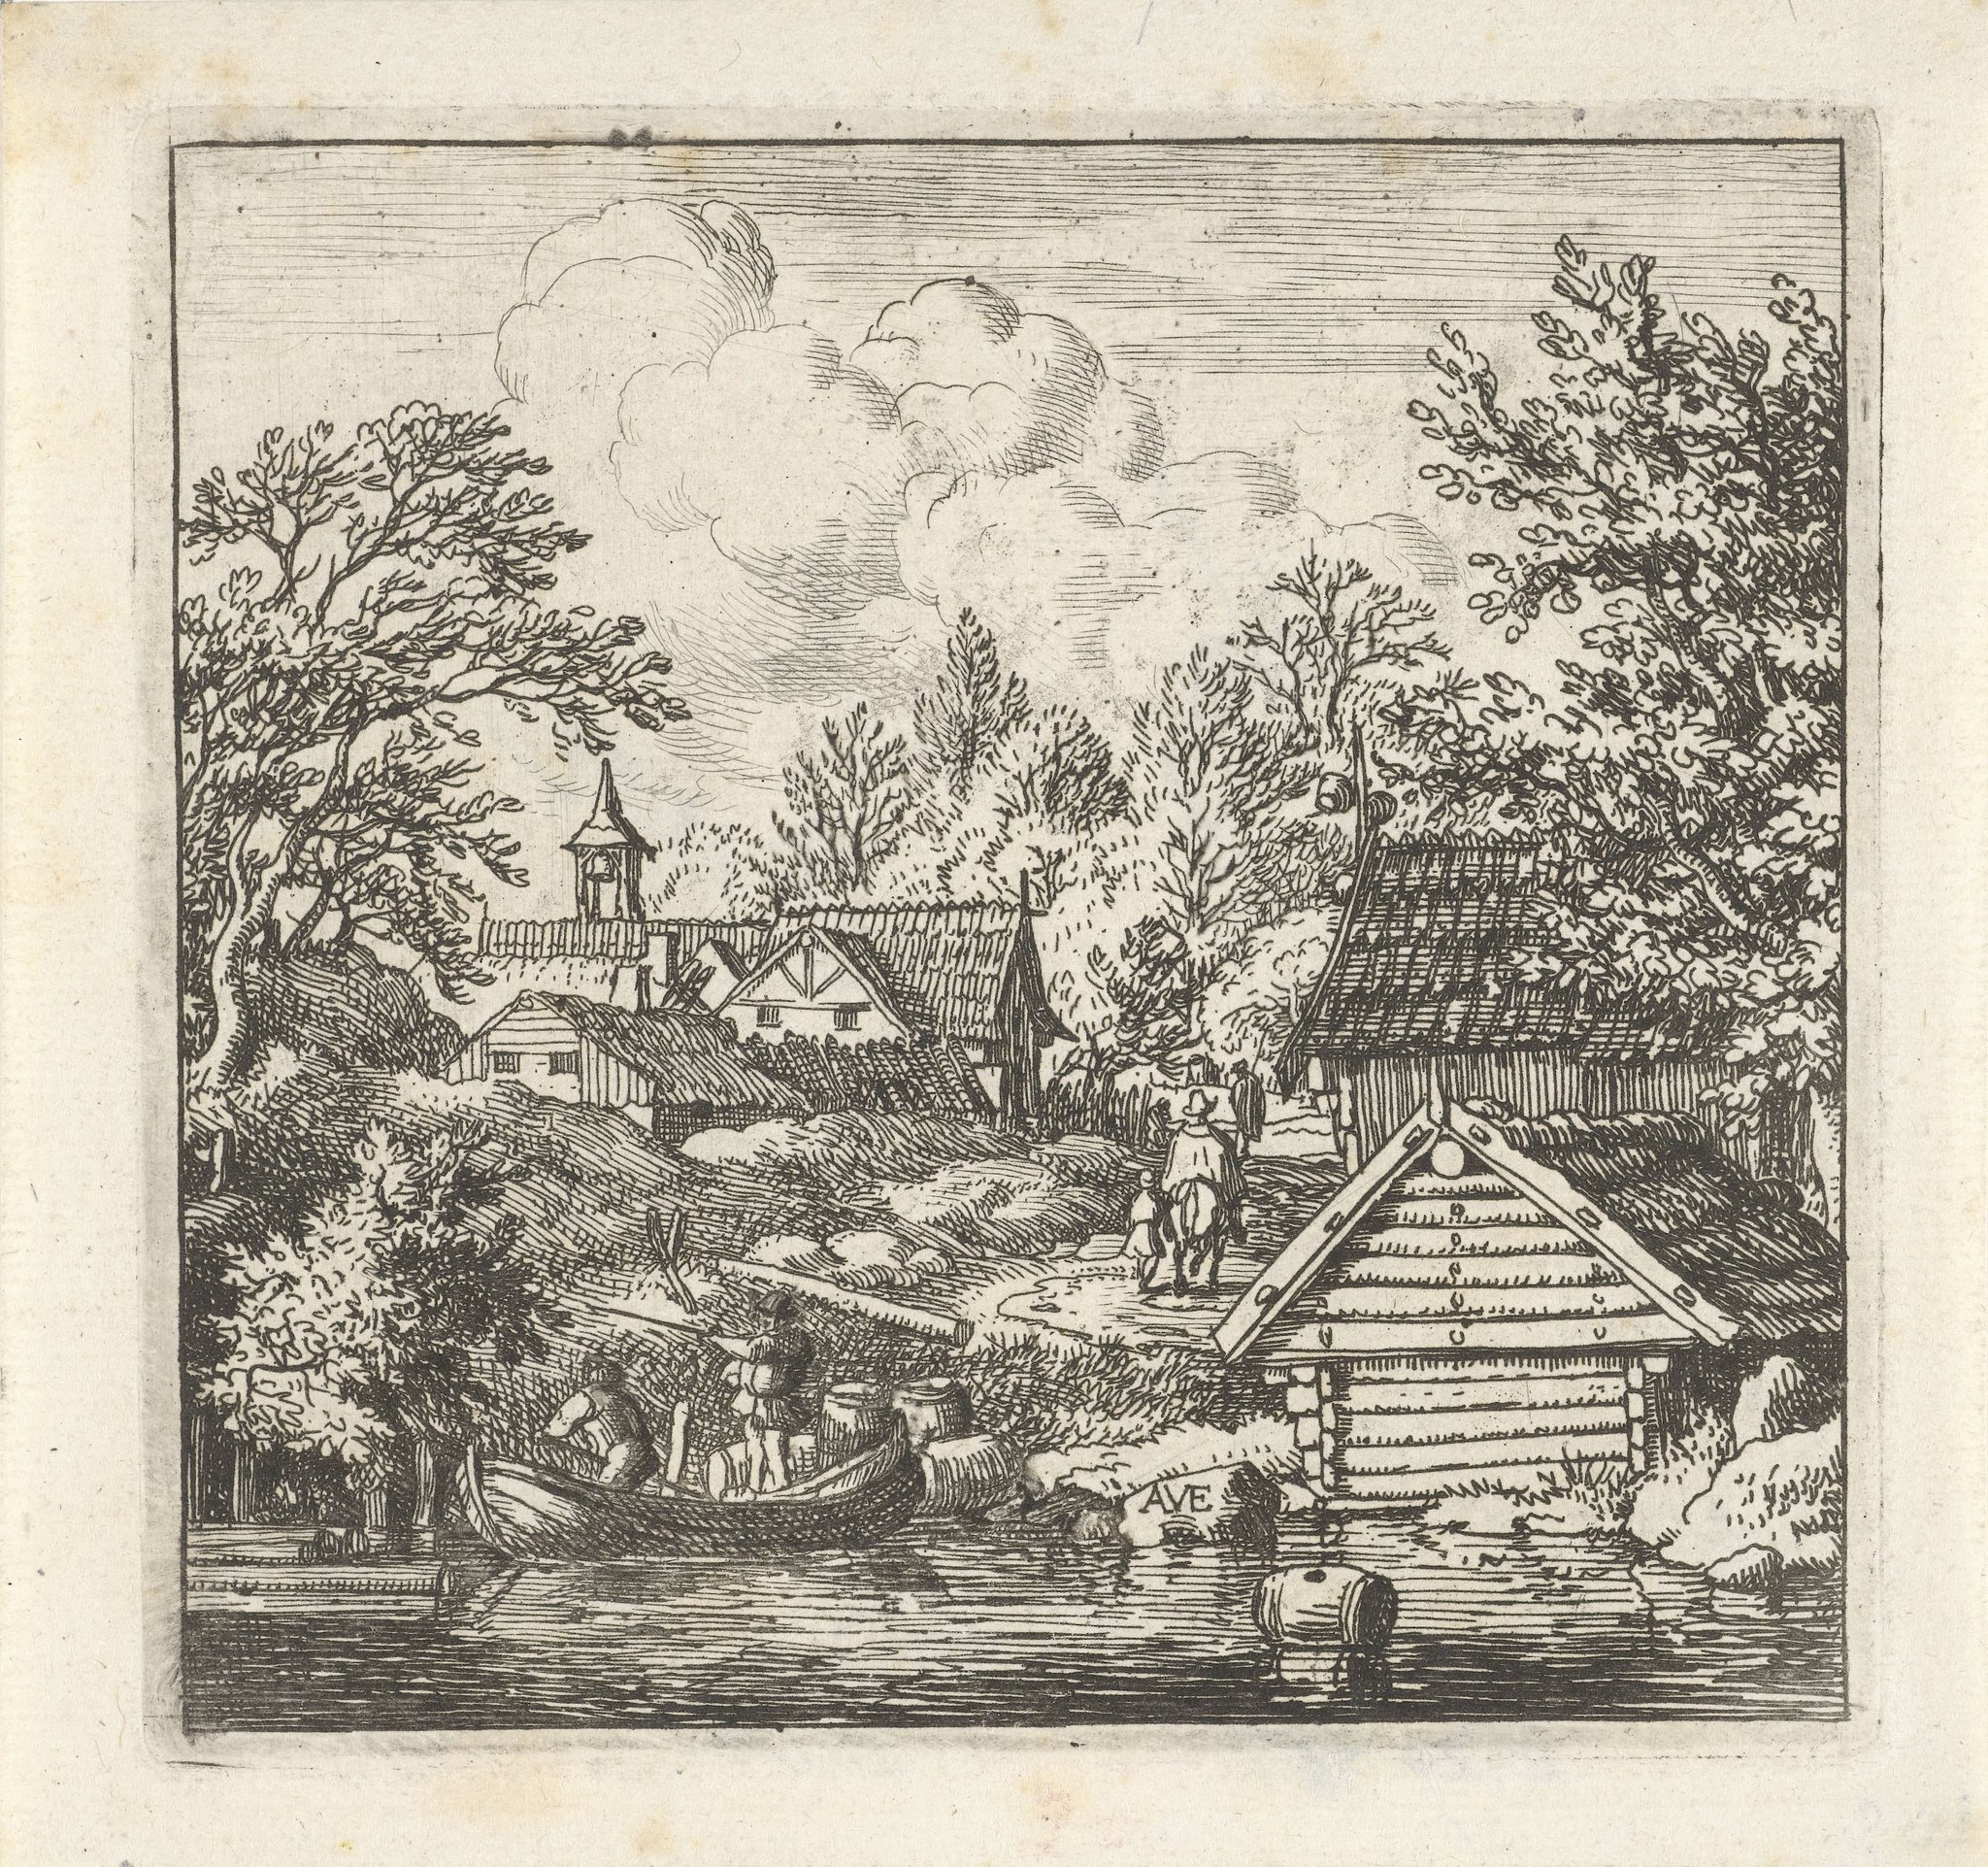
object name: print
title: De tonnen op den oever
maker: allaert van everdingen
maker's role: draughtsman, painter, print maker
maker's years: 1621-1675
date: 1631-1675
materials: paper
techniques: etching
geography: netherlands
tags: village (+ city(-scape) with figures, staffage)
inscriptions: collector's mark: Lugt 2228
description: Gezicht op een dorp aan het water. Op de voorgrond twee mannen in een schuit en op de oever enkele houten tonnen. Op de achtergrond een klokkentoren.